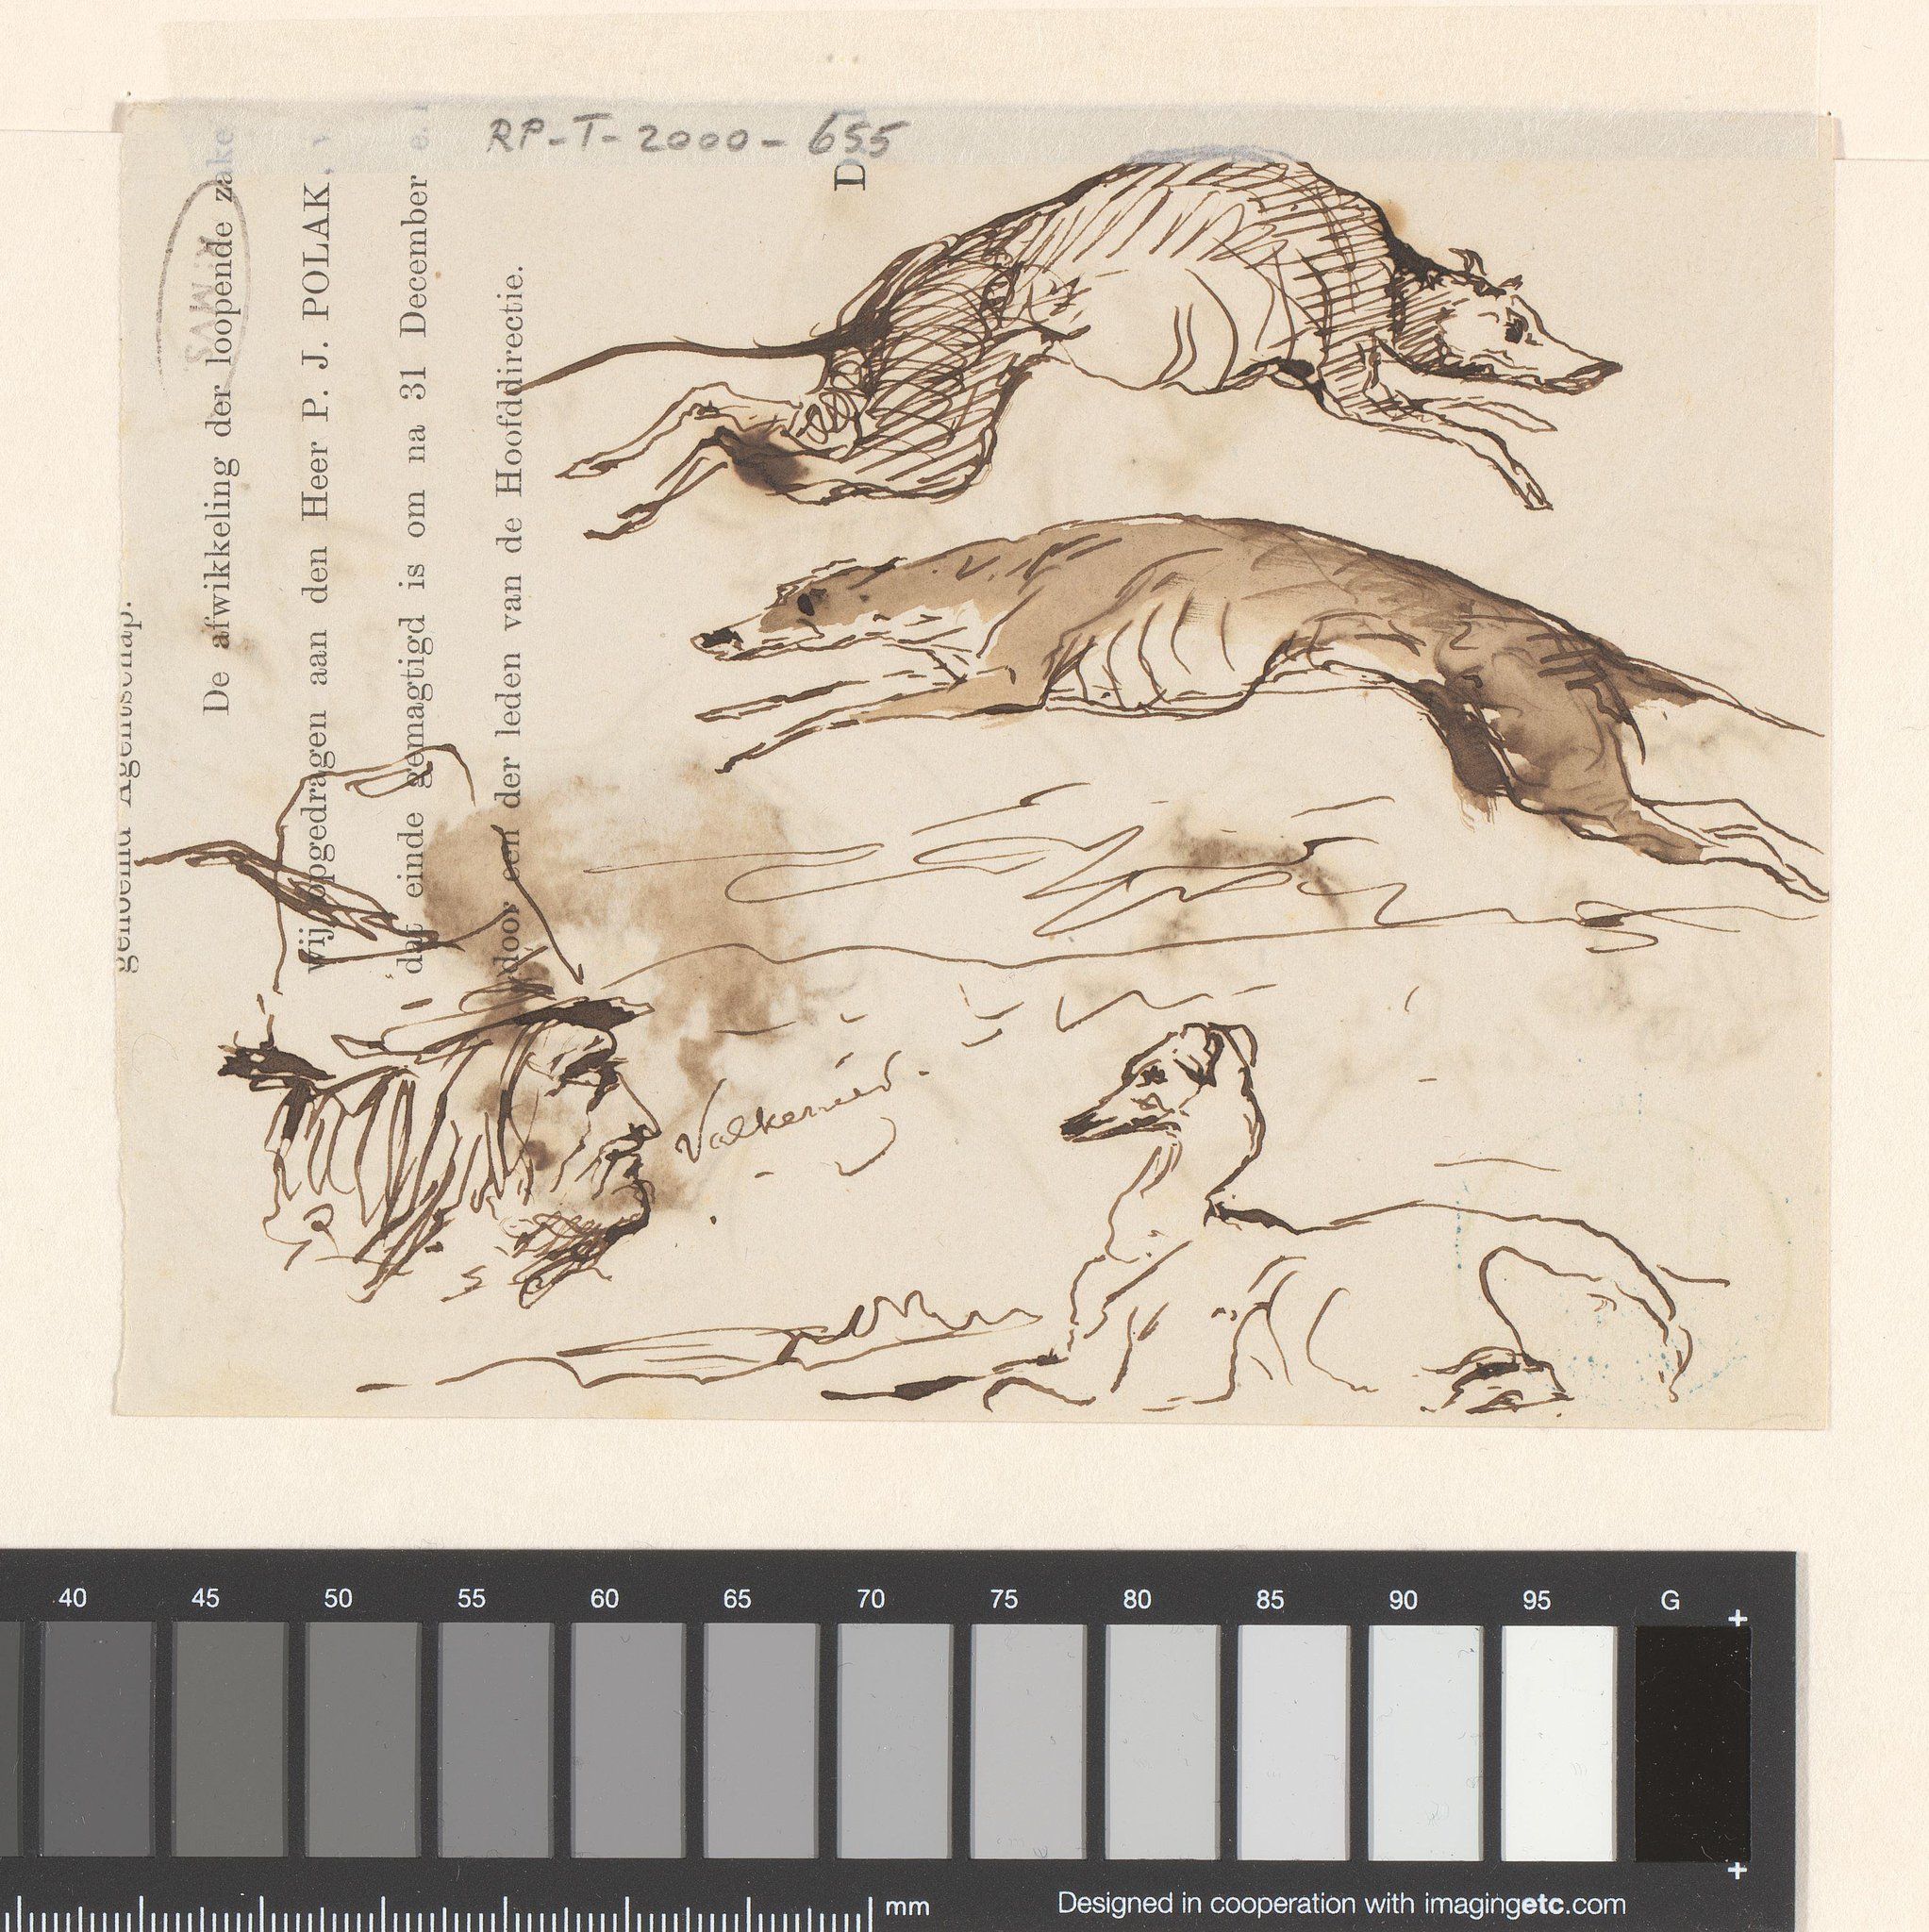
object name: drawing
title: Valkenier en windhonden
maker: johannes tavenraat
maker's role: draughtsman, painter, print maker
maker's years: 1809-1881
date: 1840-1880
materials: ink, paper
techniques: brush, pen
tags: caricatures (human types), dog (with name of kind), fowling, fowler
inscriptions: annotation: ‘Valkenier’, collector's mark: Lugt 2228, signature: ‘Tavenraat’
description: Valkenier en windhonden. Getekend op een fragment van een drukwerk, met franco stempel op de voorzijde.